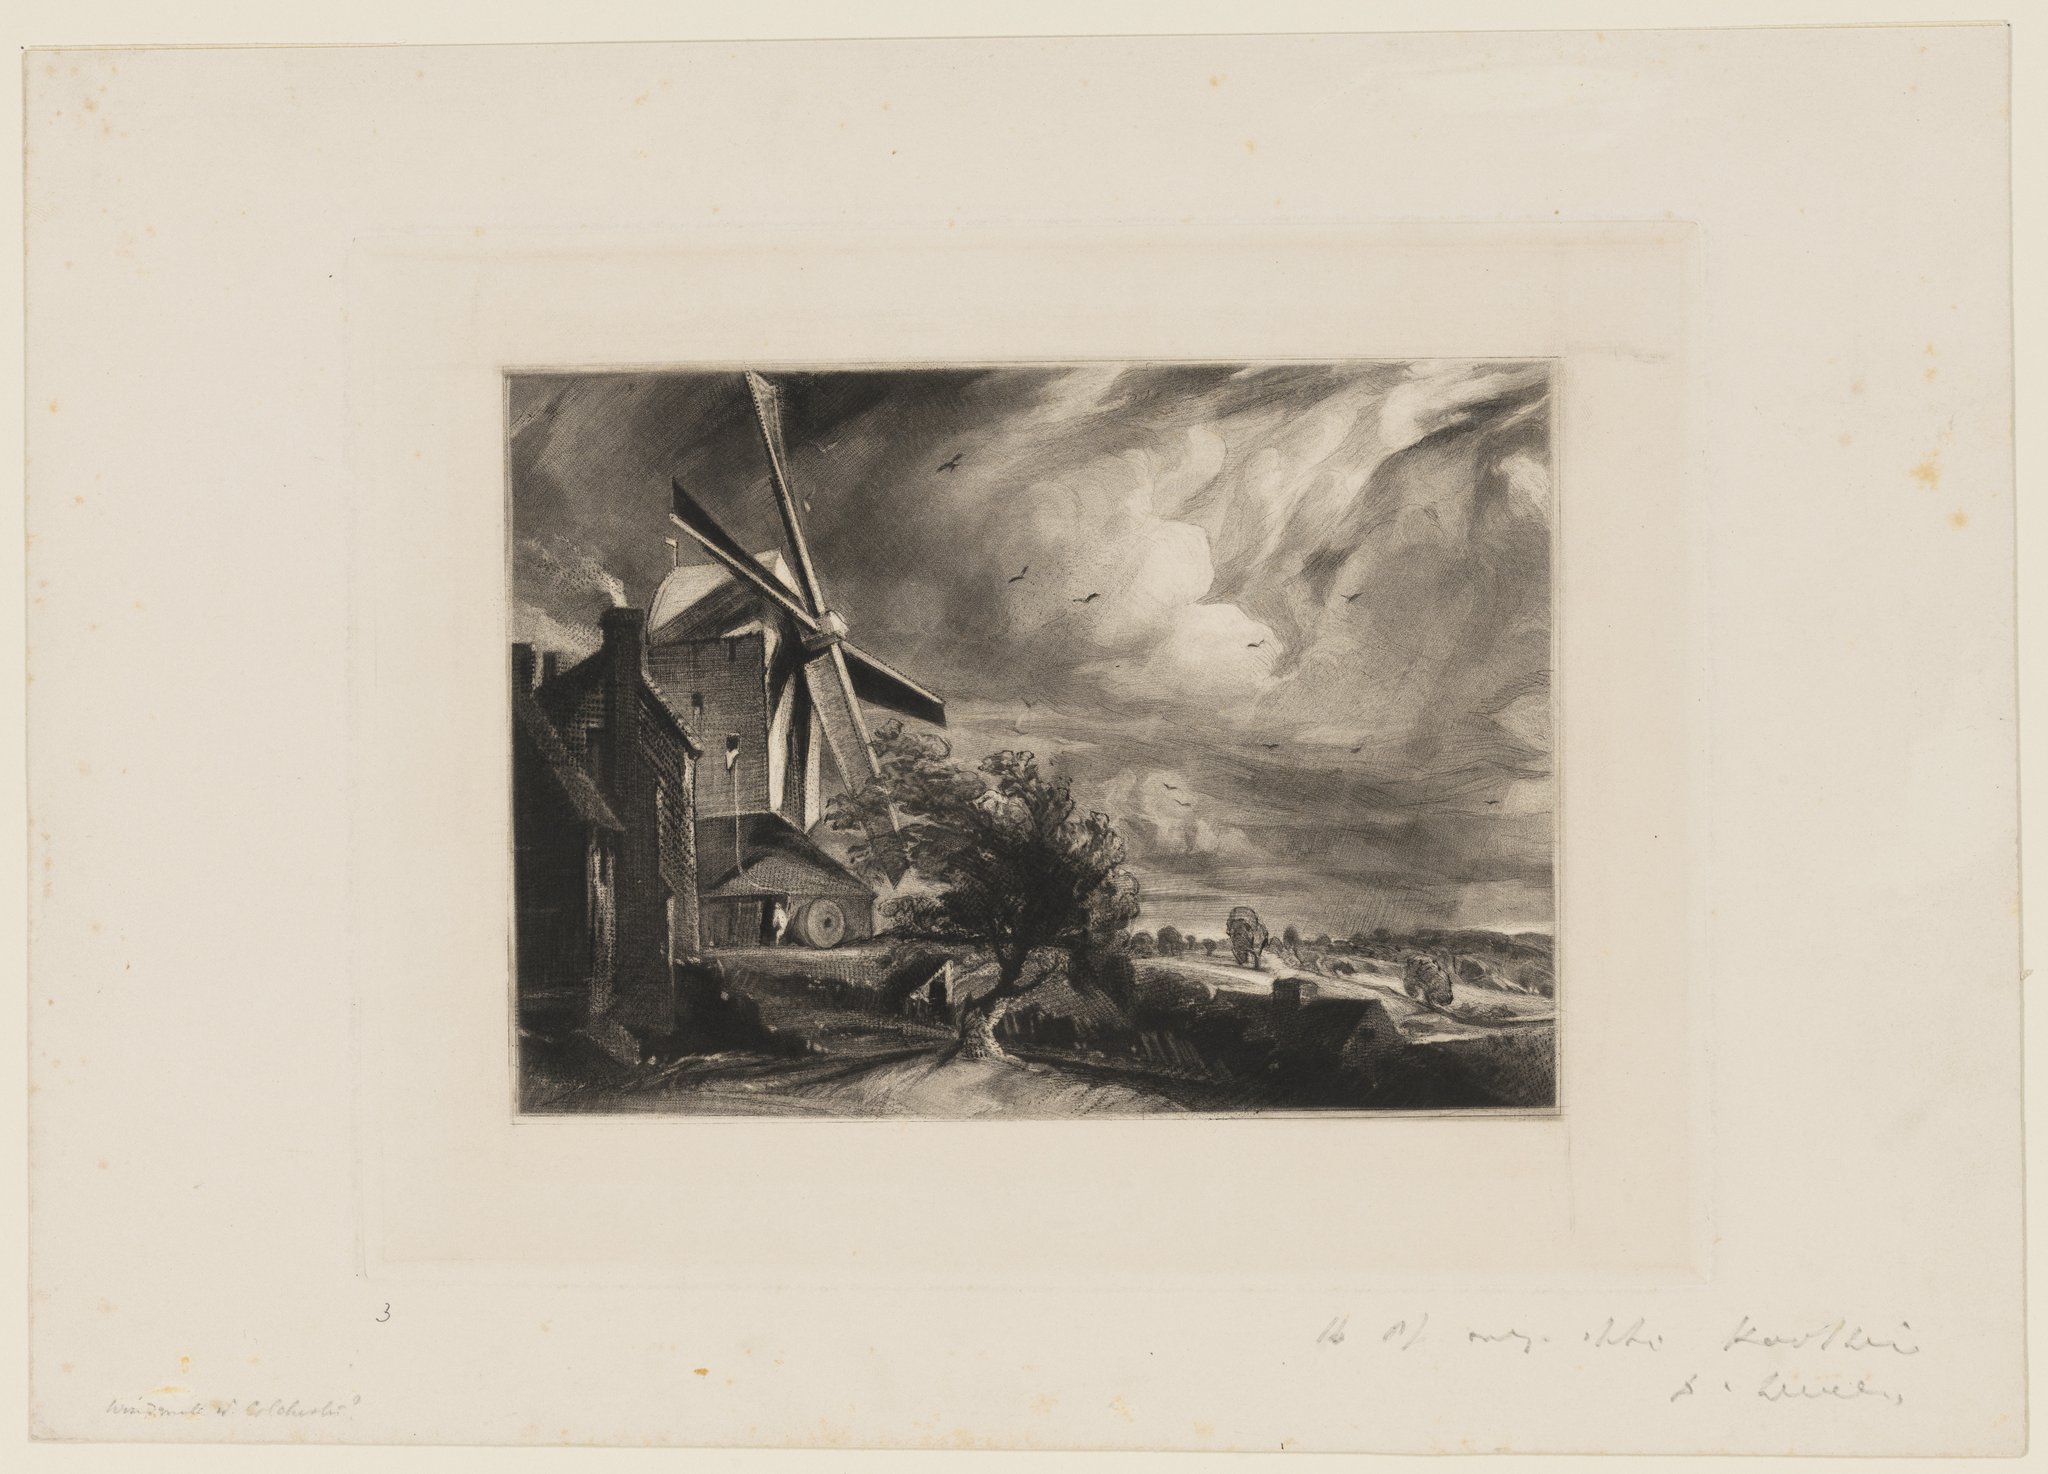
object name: print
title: Mill near Colchester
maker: david lucas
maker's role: engraver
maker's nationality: british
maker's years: 1802-1881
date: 1845-1846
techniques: mezzotint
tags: windmills